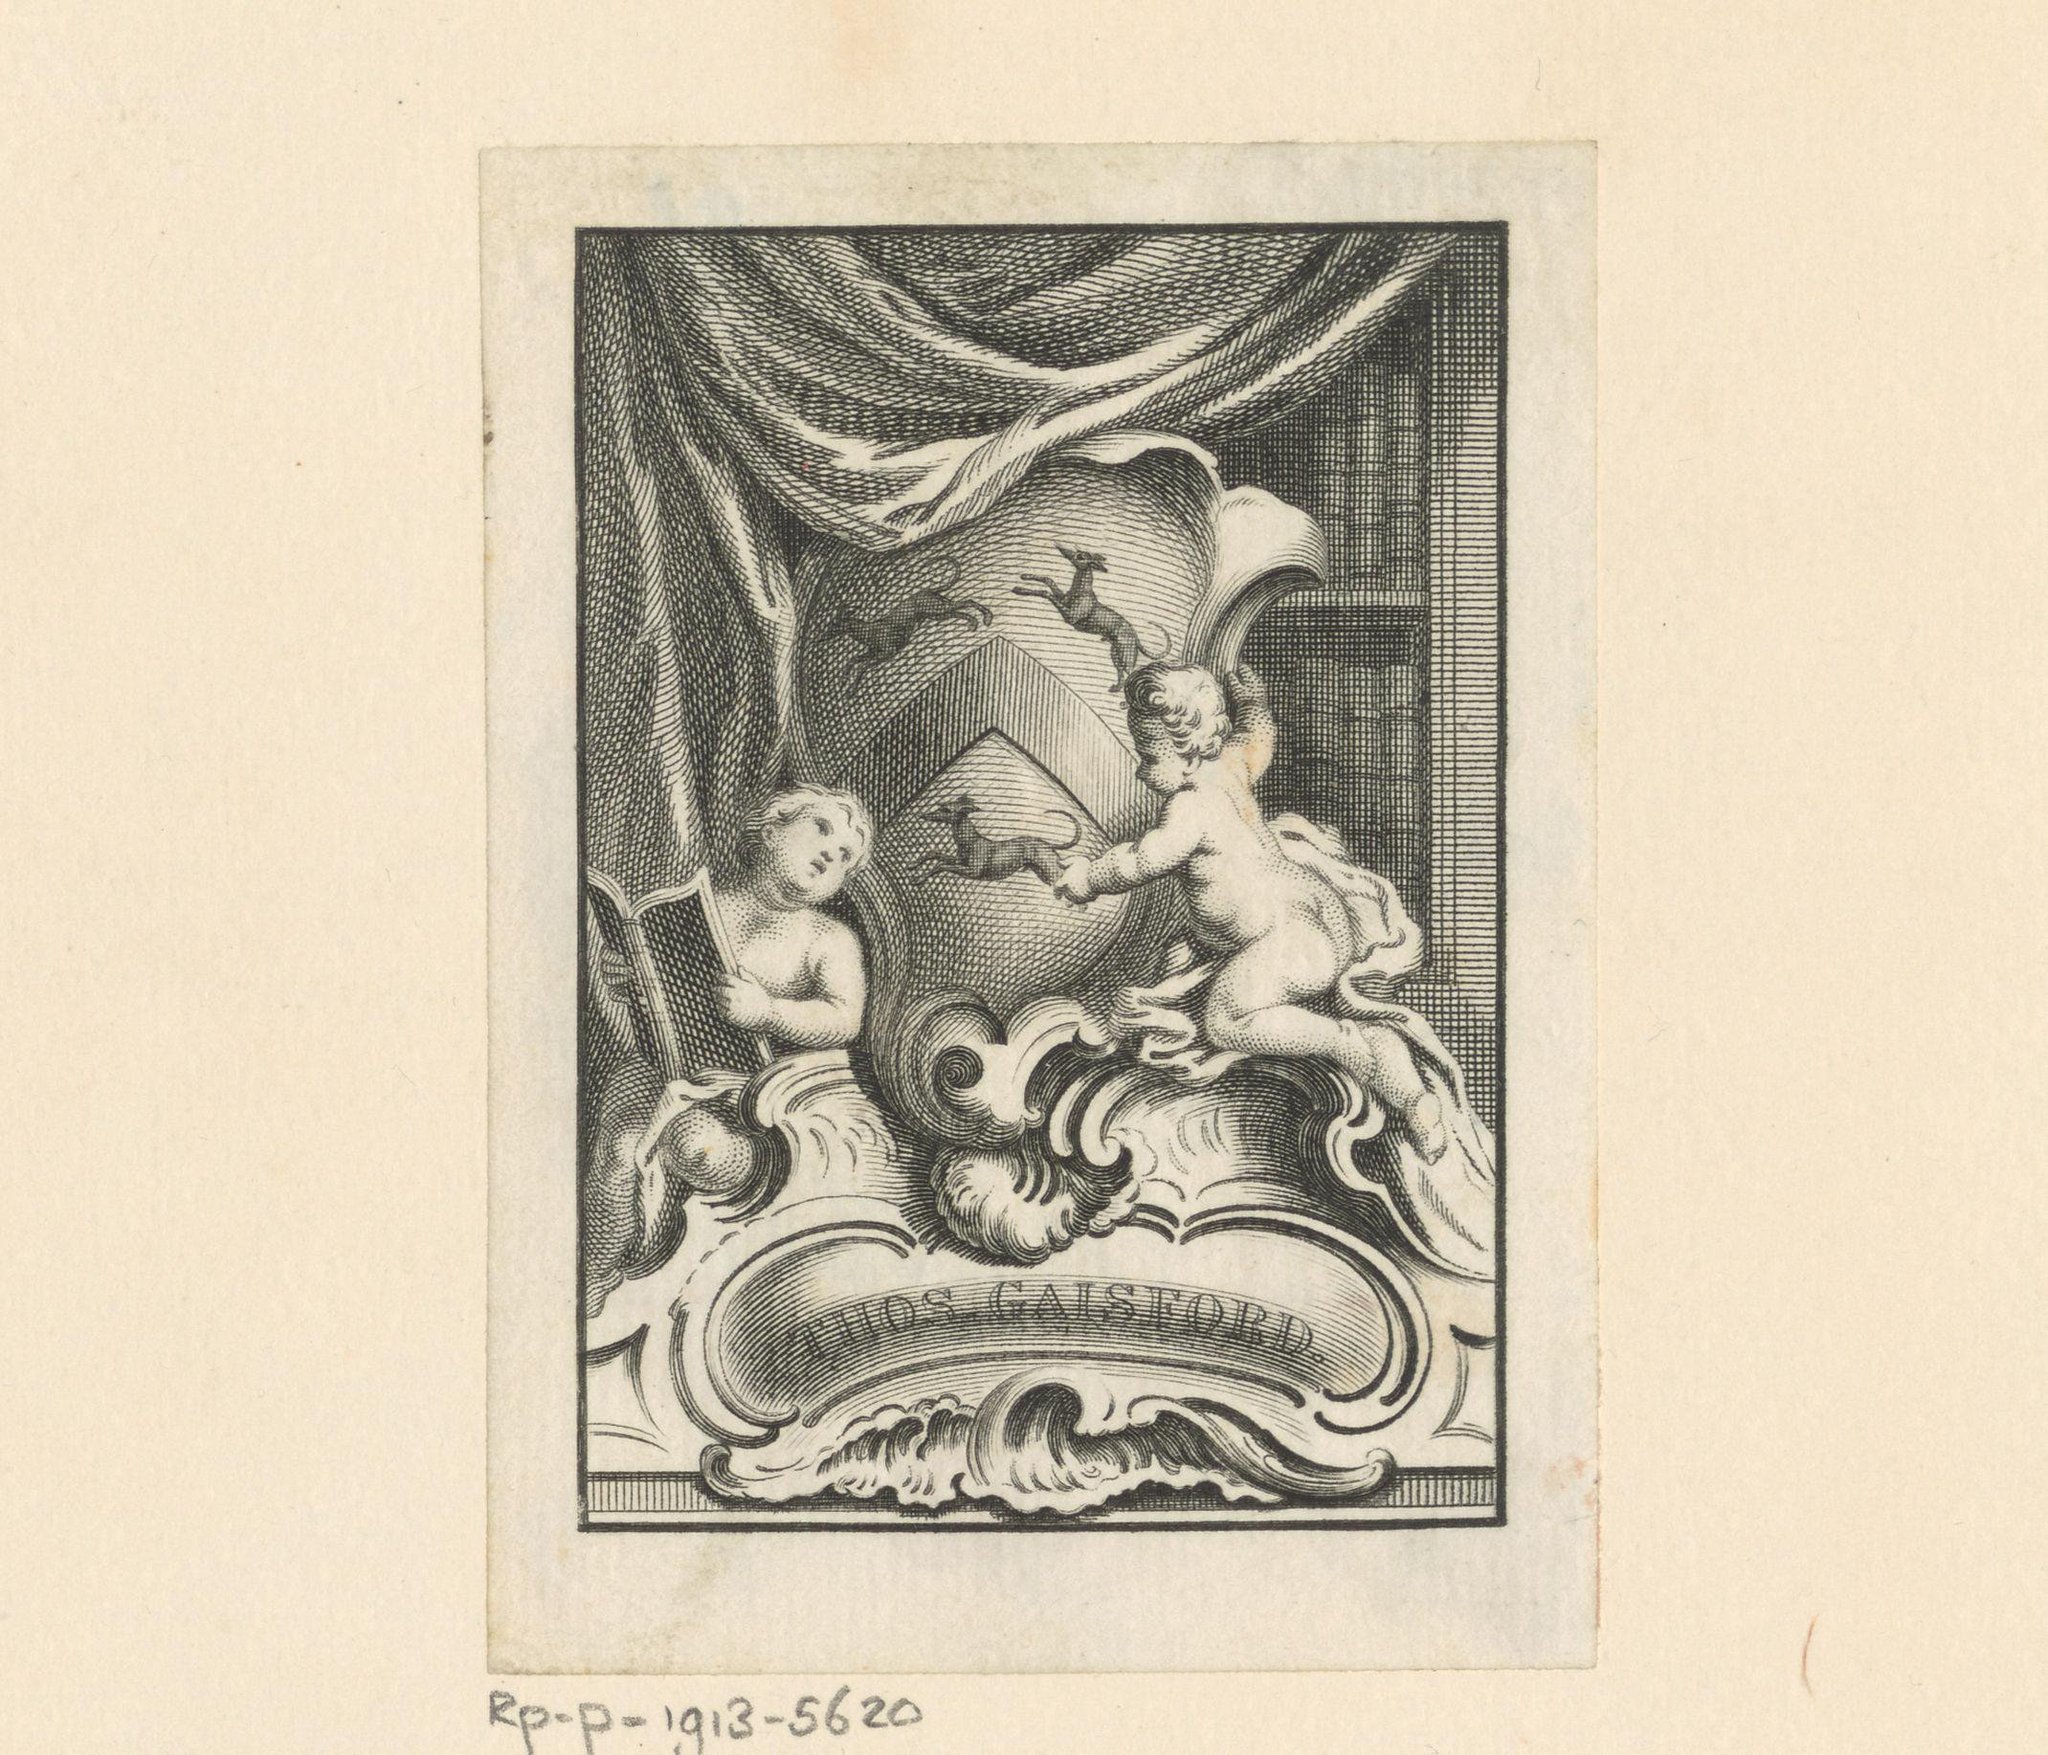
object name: bookplate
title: Ex libris van Thos. Gaisford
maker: Anonymous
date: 1750-1849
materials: paper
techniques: engraving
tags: armorial bearing, heraldry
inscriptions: collector's mark: Lugt 2233, collector's mark: Lugt 2760